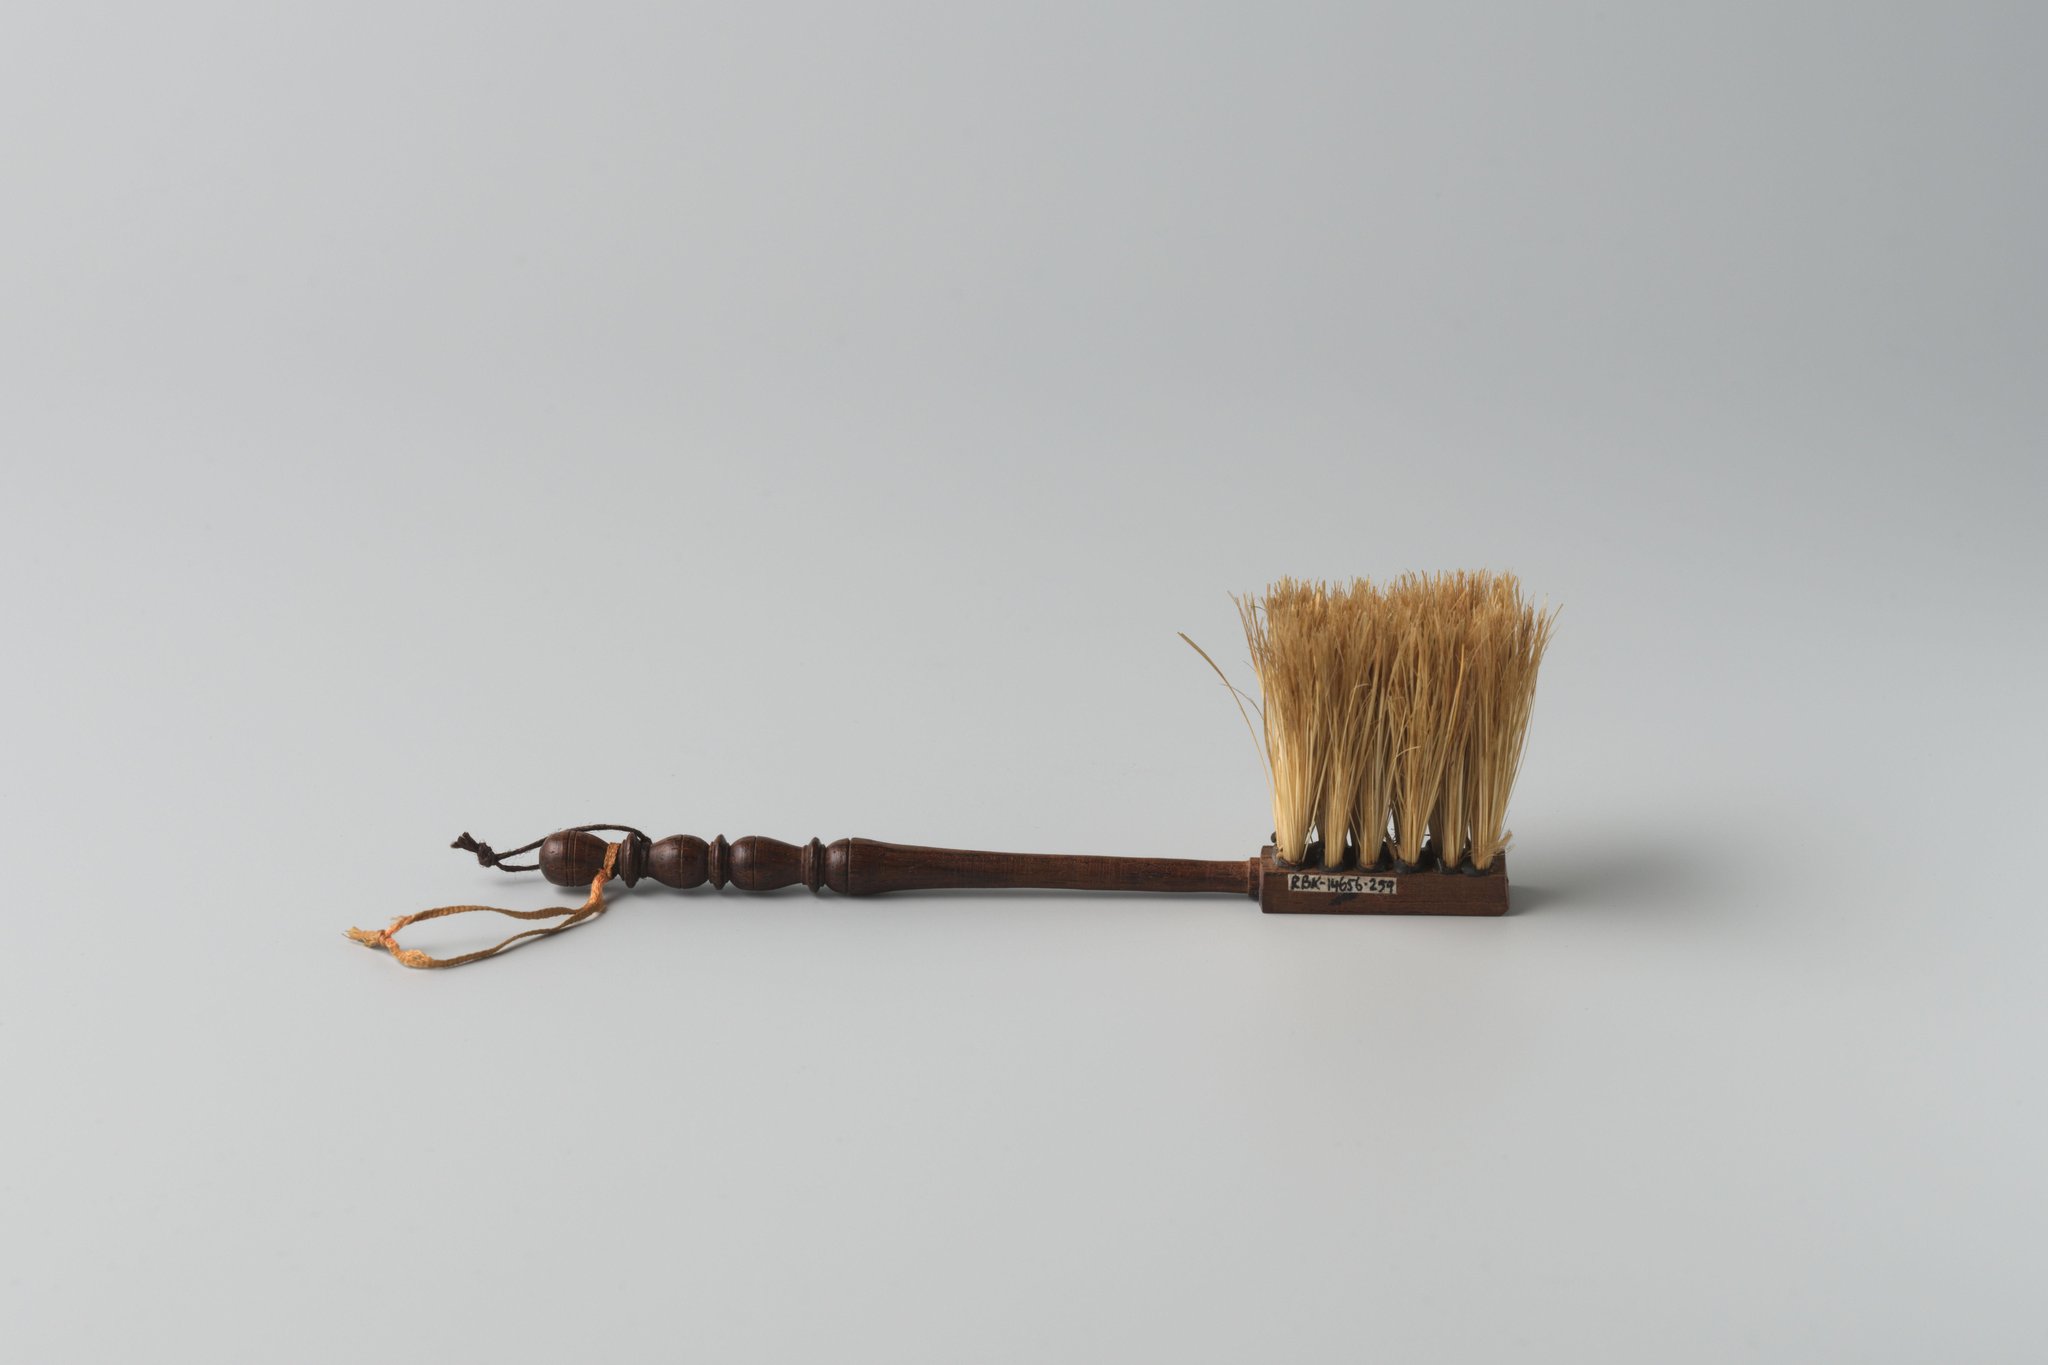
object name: whisk broom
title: Stoffer van palissanderhout en varkenshaar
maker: Anonymous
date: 1676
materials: wood, silk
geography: amsterdam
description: Stoffer van palissanderhout en varkenshaar. De stoffer heeft een rechthoekige kop, waaraan een gedraaide steel met balusters en profielen versierd. Om de knop een roze zijden lint.